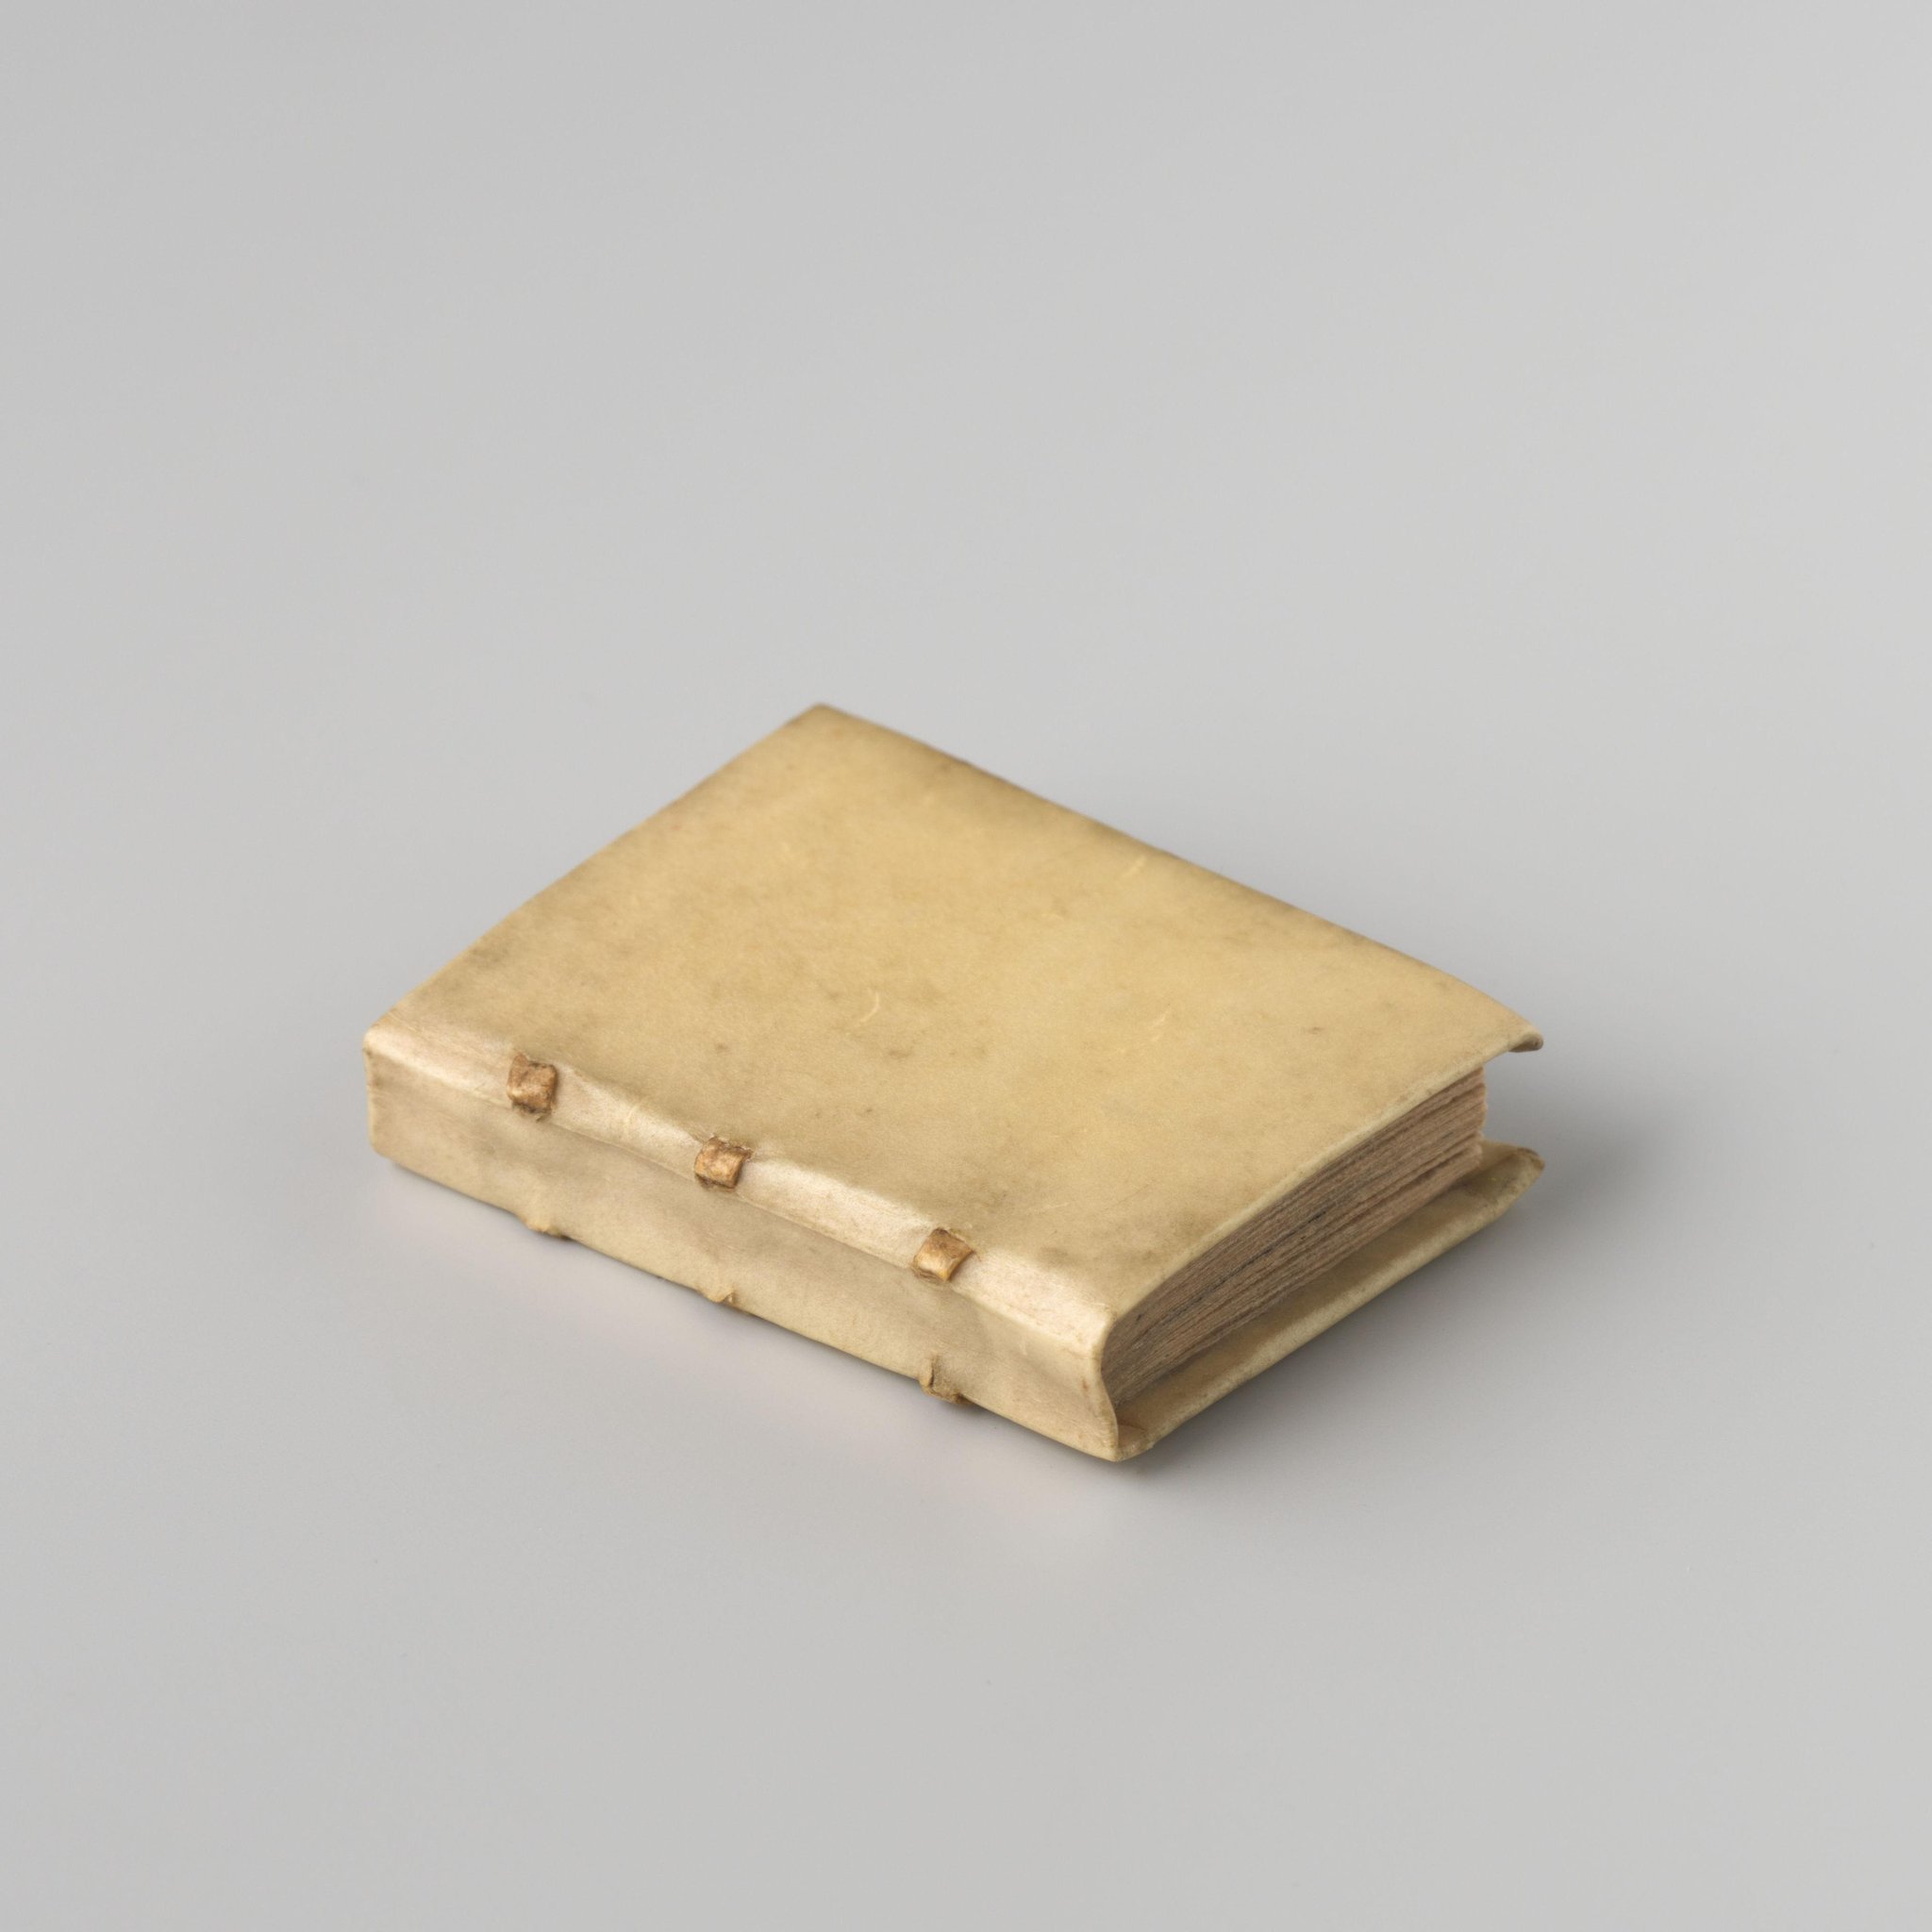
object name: book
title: Tuingezichten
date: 1690-1710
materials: paper, parchment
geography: amsterdam